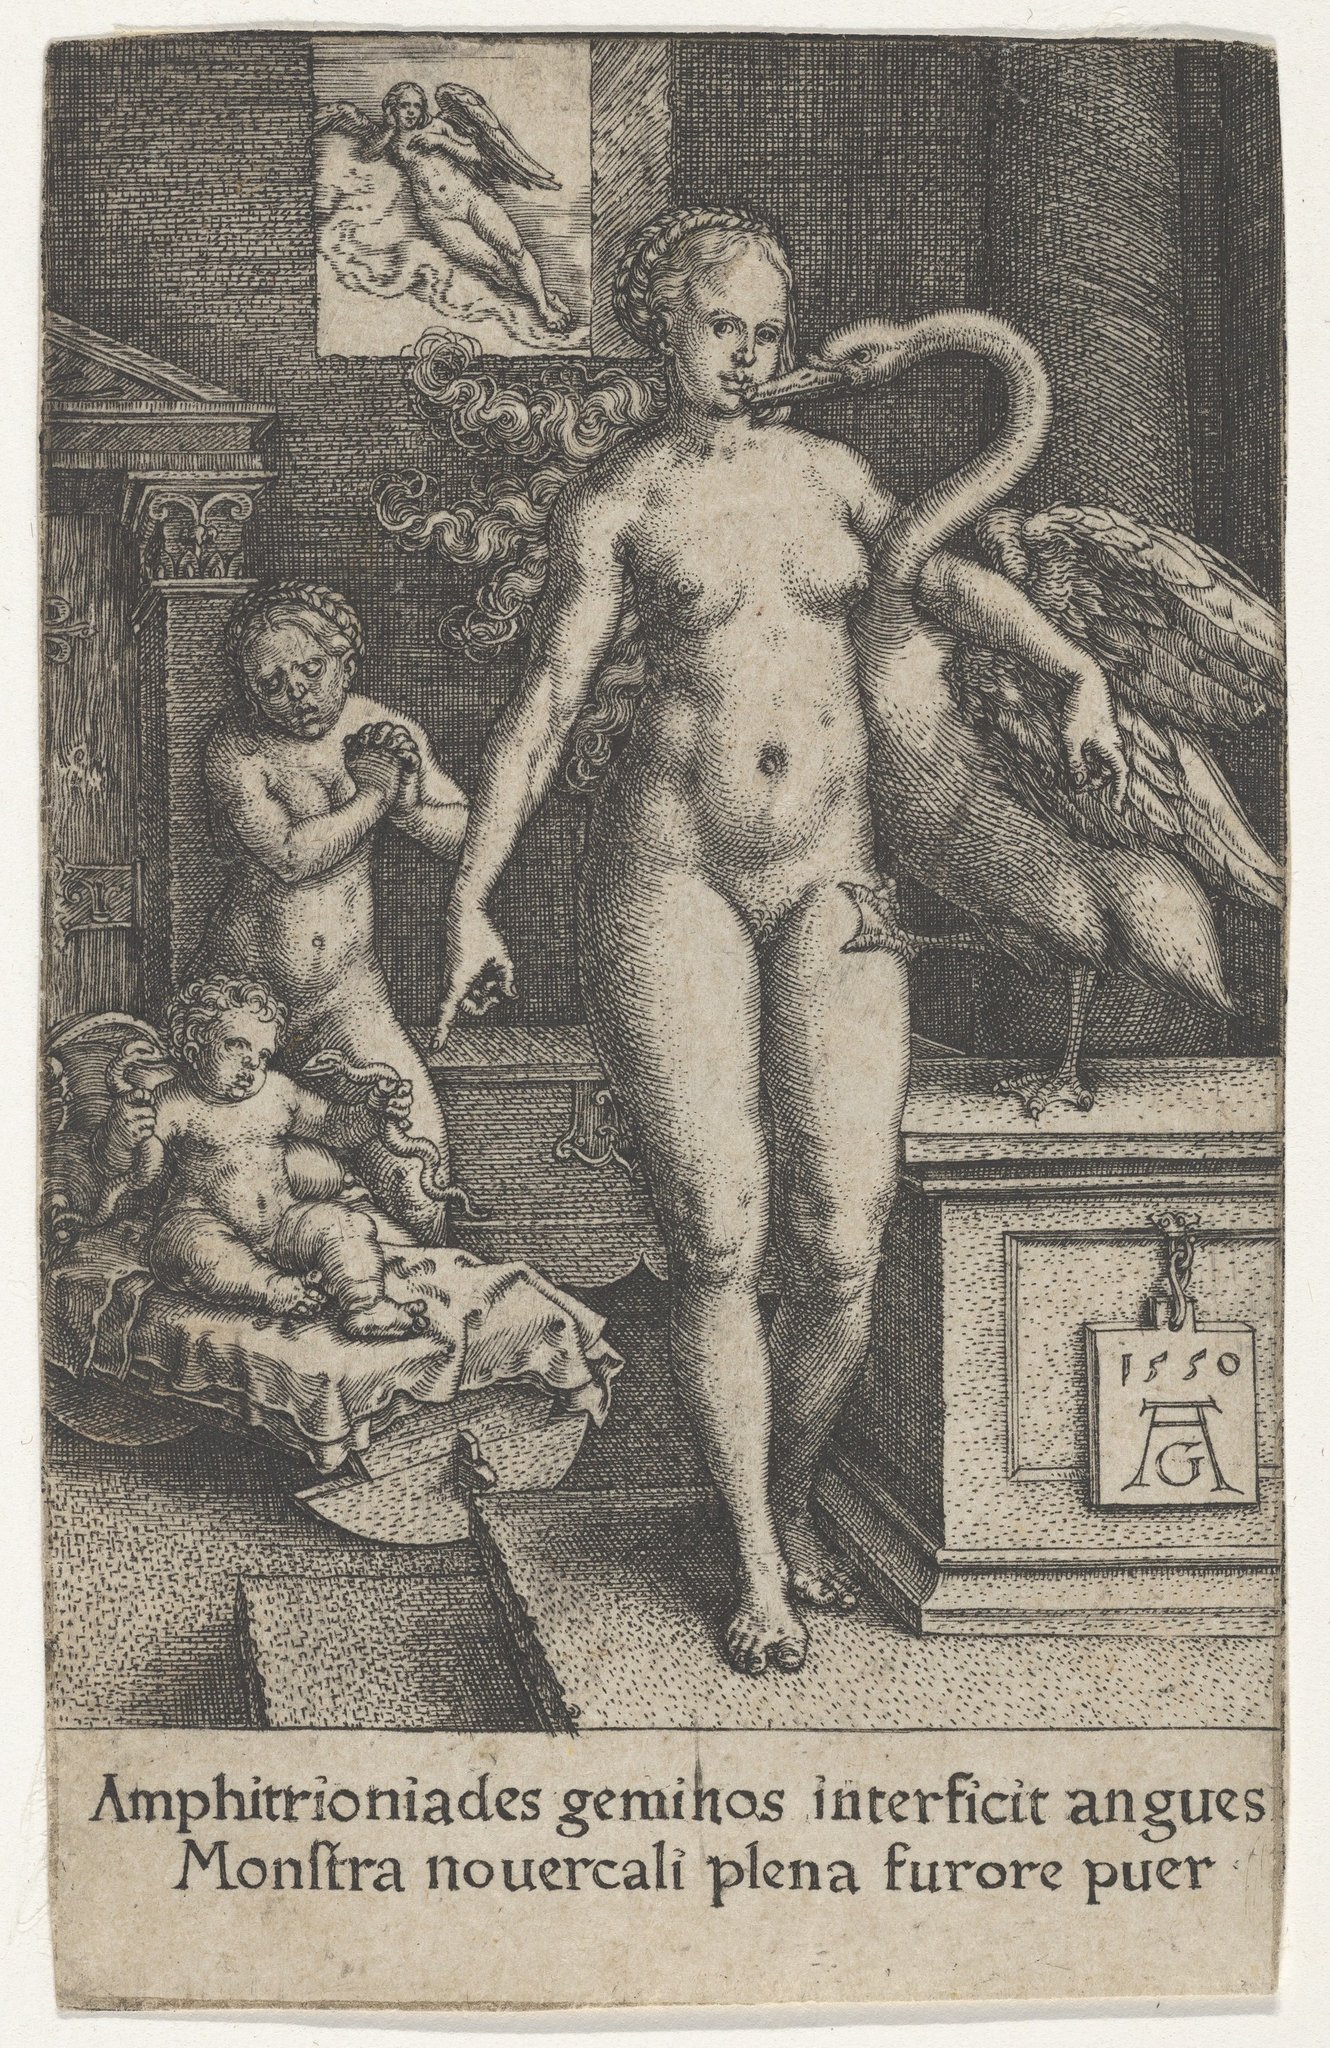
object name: print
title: Leda with the Swan and Hercules as a Child, from "The Labors of Hercules"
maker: heinrich aldegrever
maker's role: artist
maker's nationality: german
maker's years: 1502-1561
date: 1550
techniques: engraving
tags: hercules,leda,swans